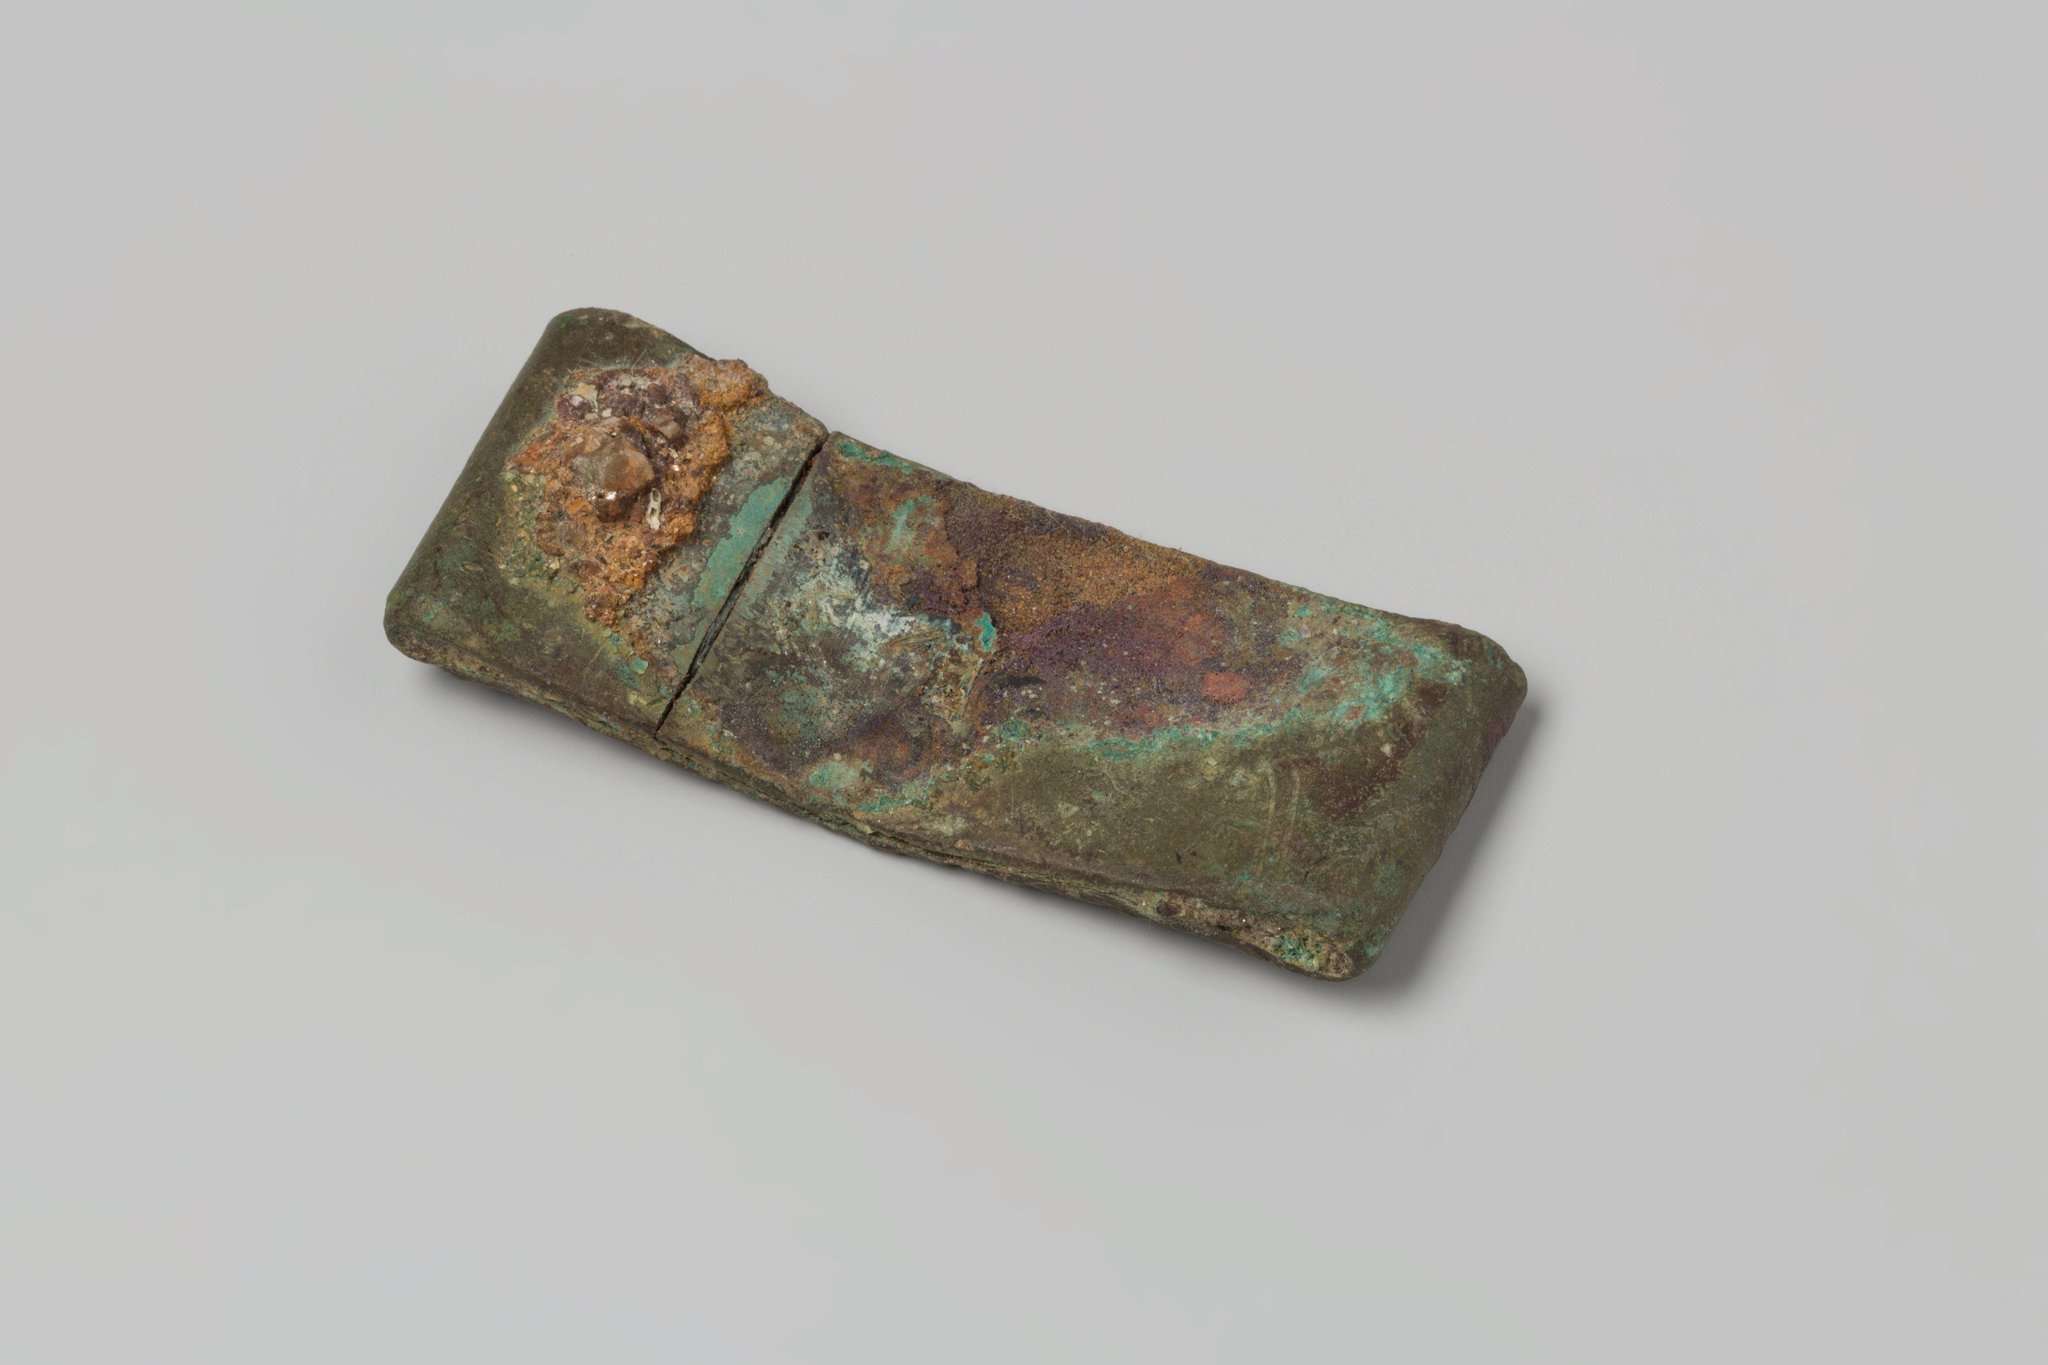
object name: firehose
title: Brandslangring uit het wrak van de Oost-Indiëvaarder Hollandia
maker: Anonymous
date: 1700-1743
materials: copper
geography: netherlands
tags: verenigde oostindische compagnie, hollandia (schip), annet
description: Firehose, fragm, id. NG 1975-20H1271a, squashed.